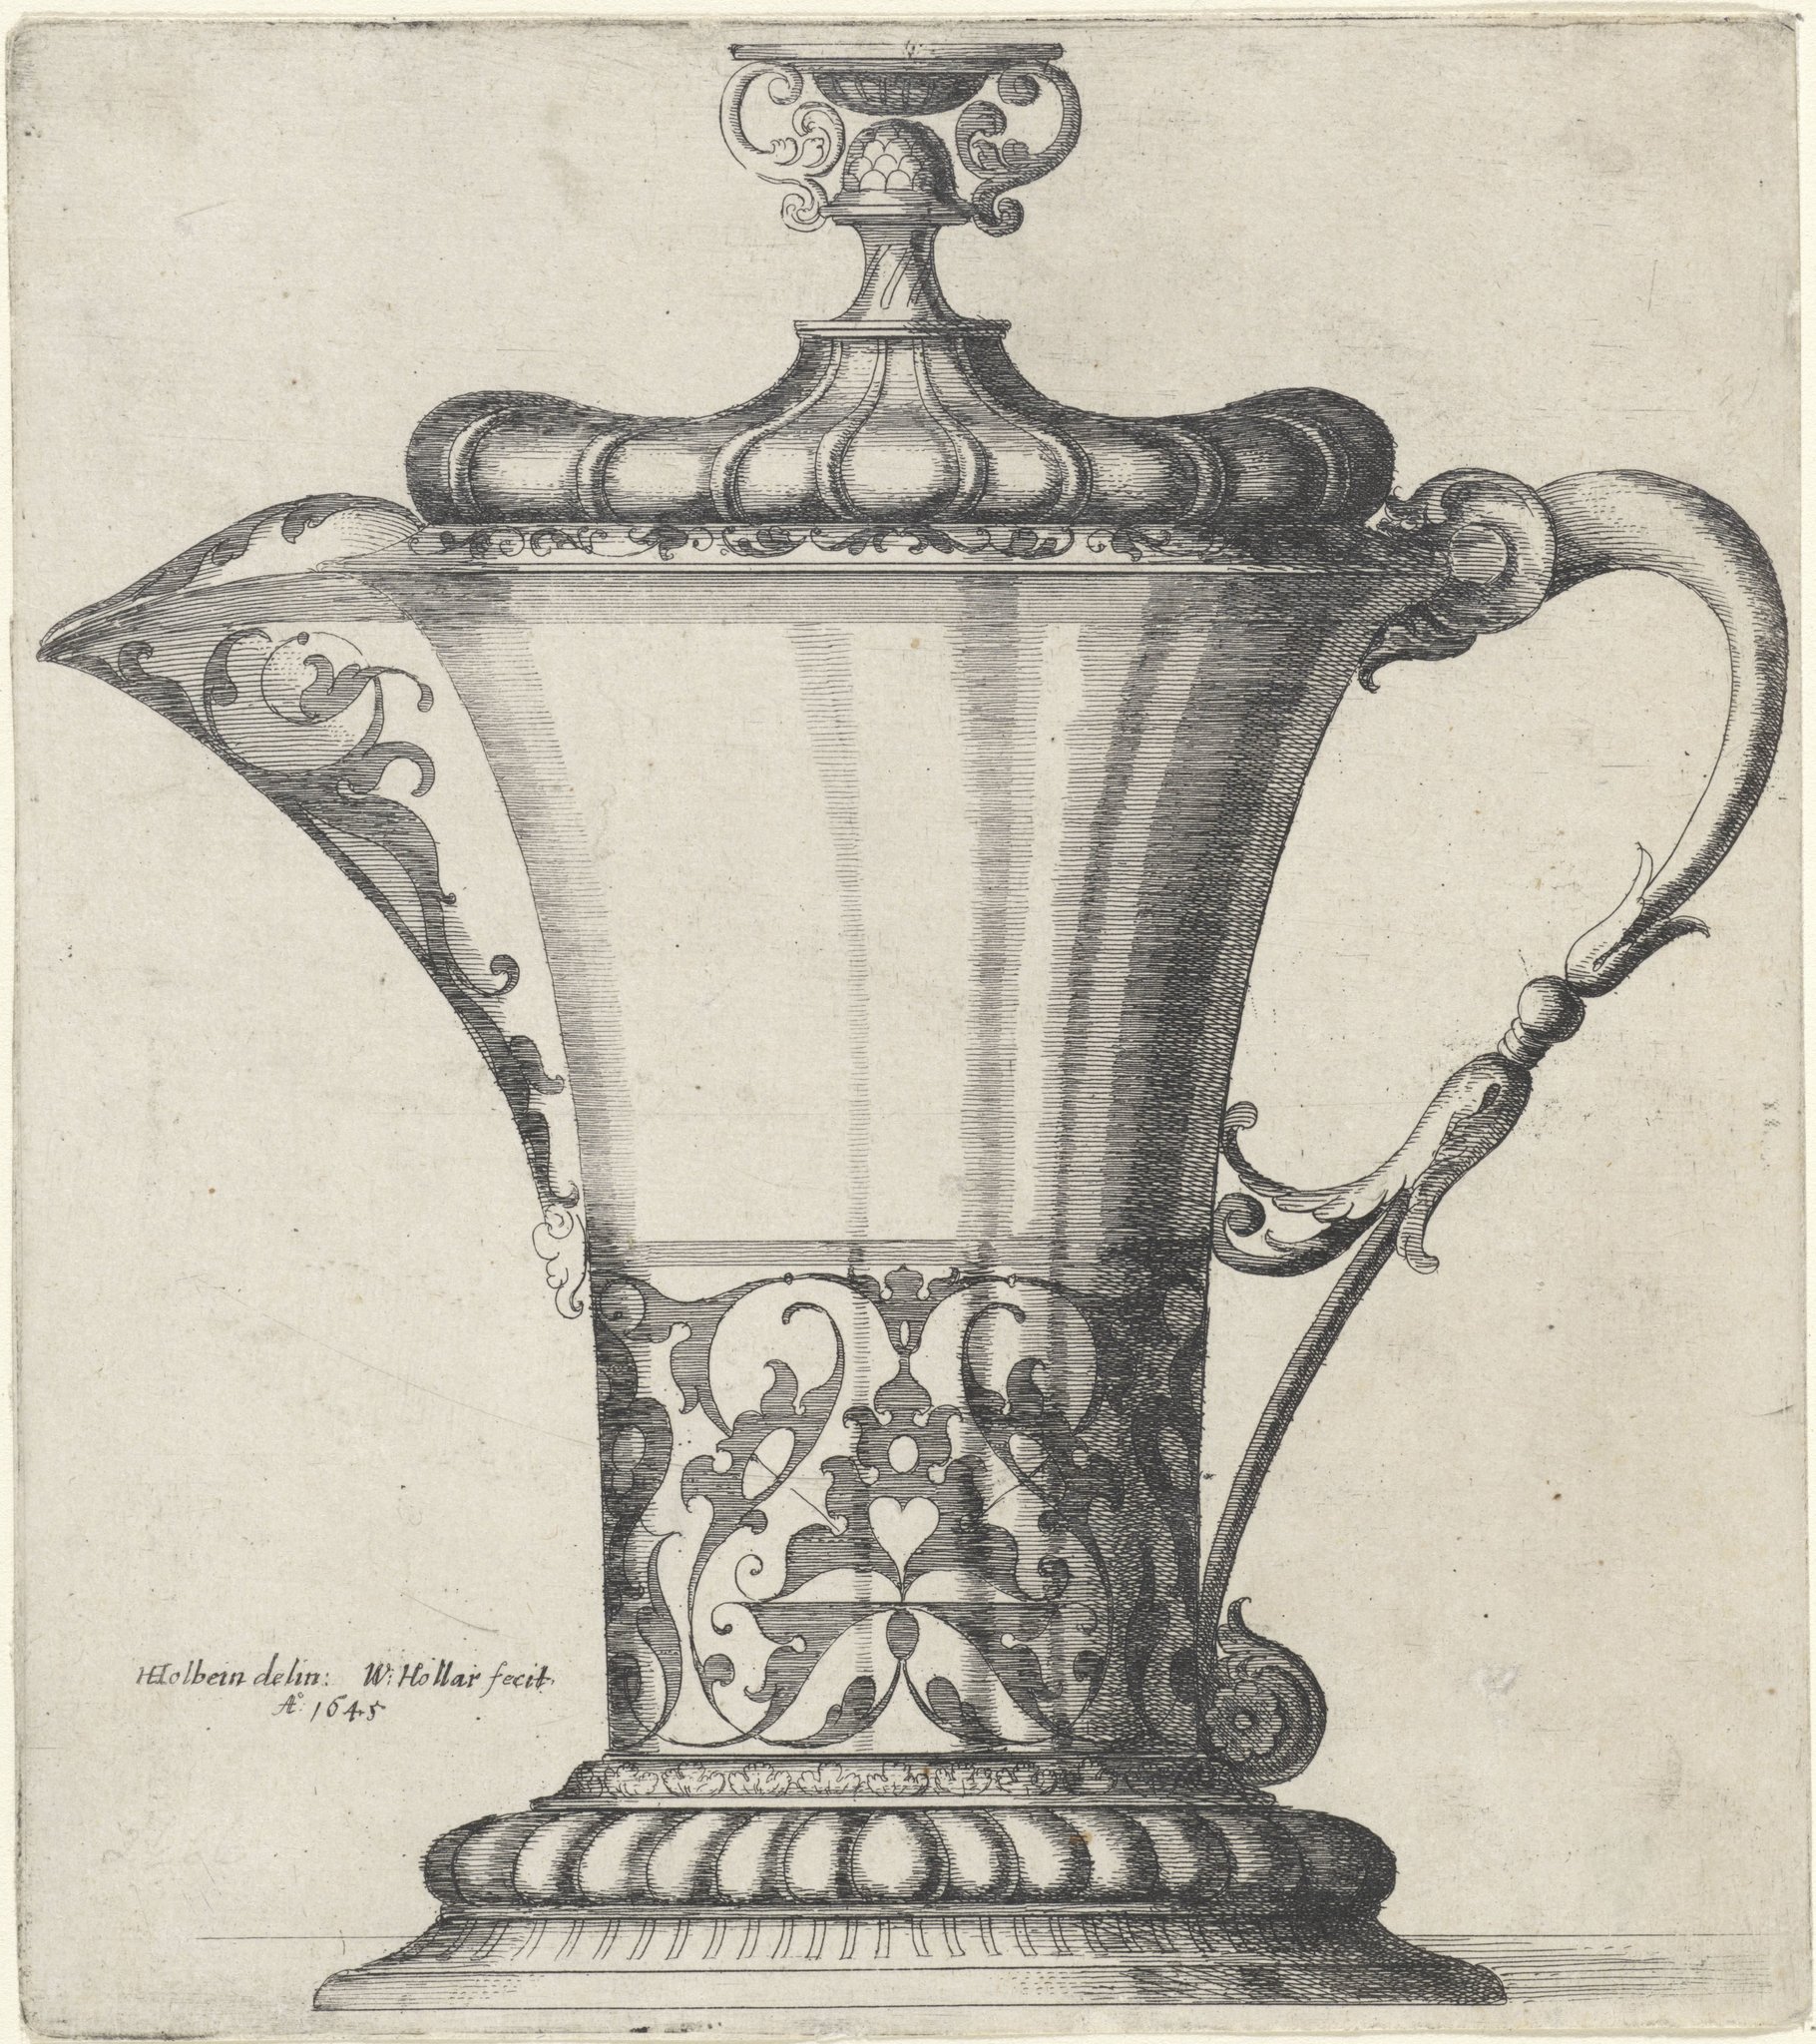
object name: print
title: Ornamentele kan met deksel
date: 1645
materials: paper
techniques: etching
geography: antwerp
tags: laid table: table-ware, table-decoration, etc.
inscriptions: collector's mark: Lugt 2773, collector's mark: Lugt 2228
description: Prent maakt deel uit van een tiendelige serie met ornamentele schalen en kannen.